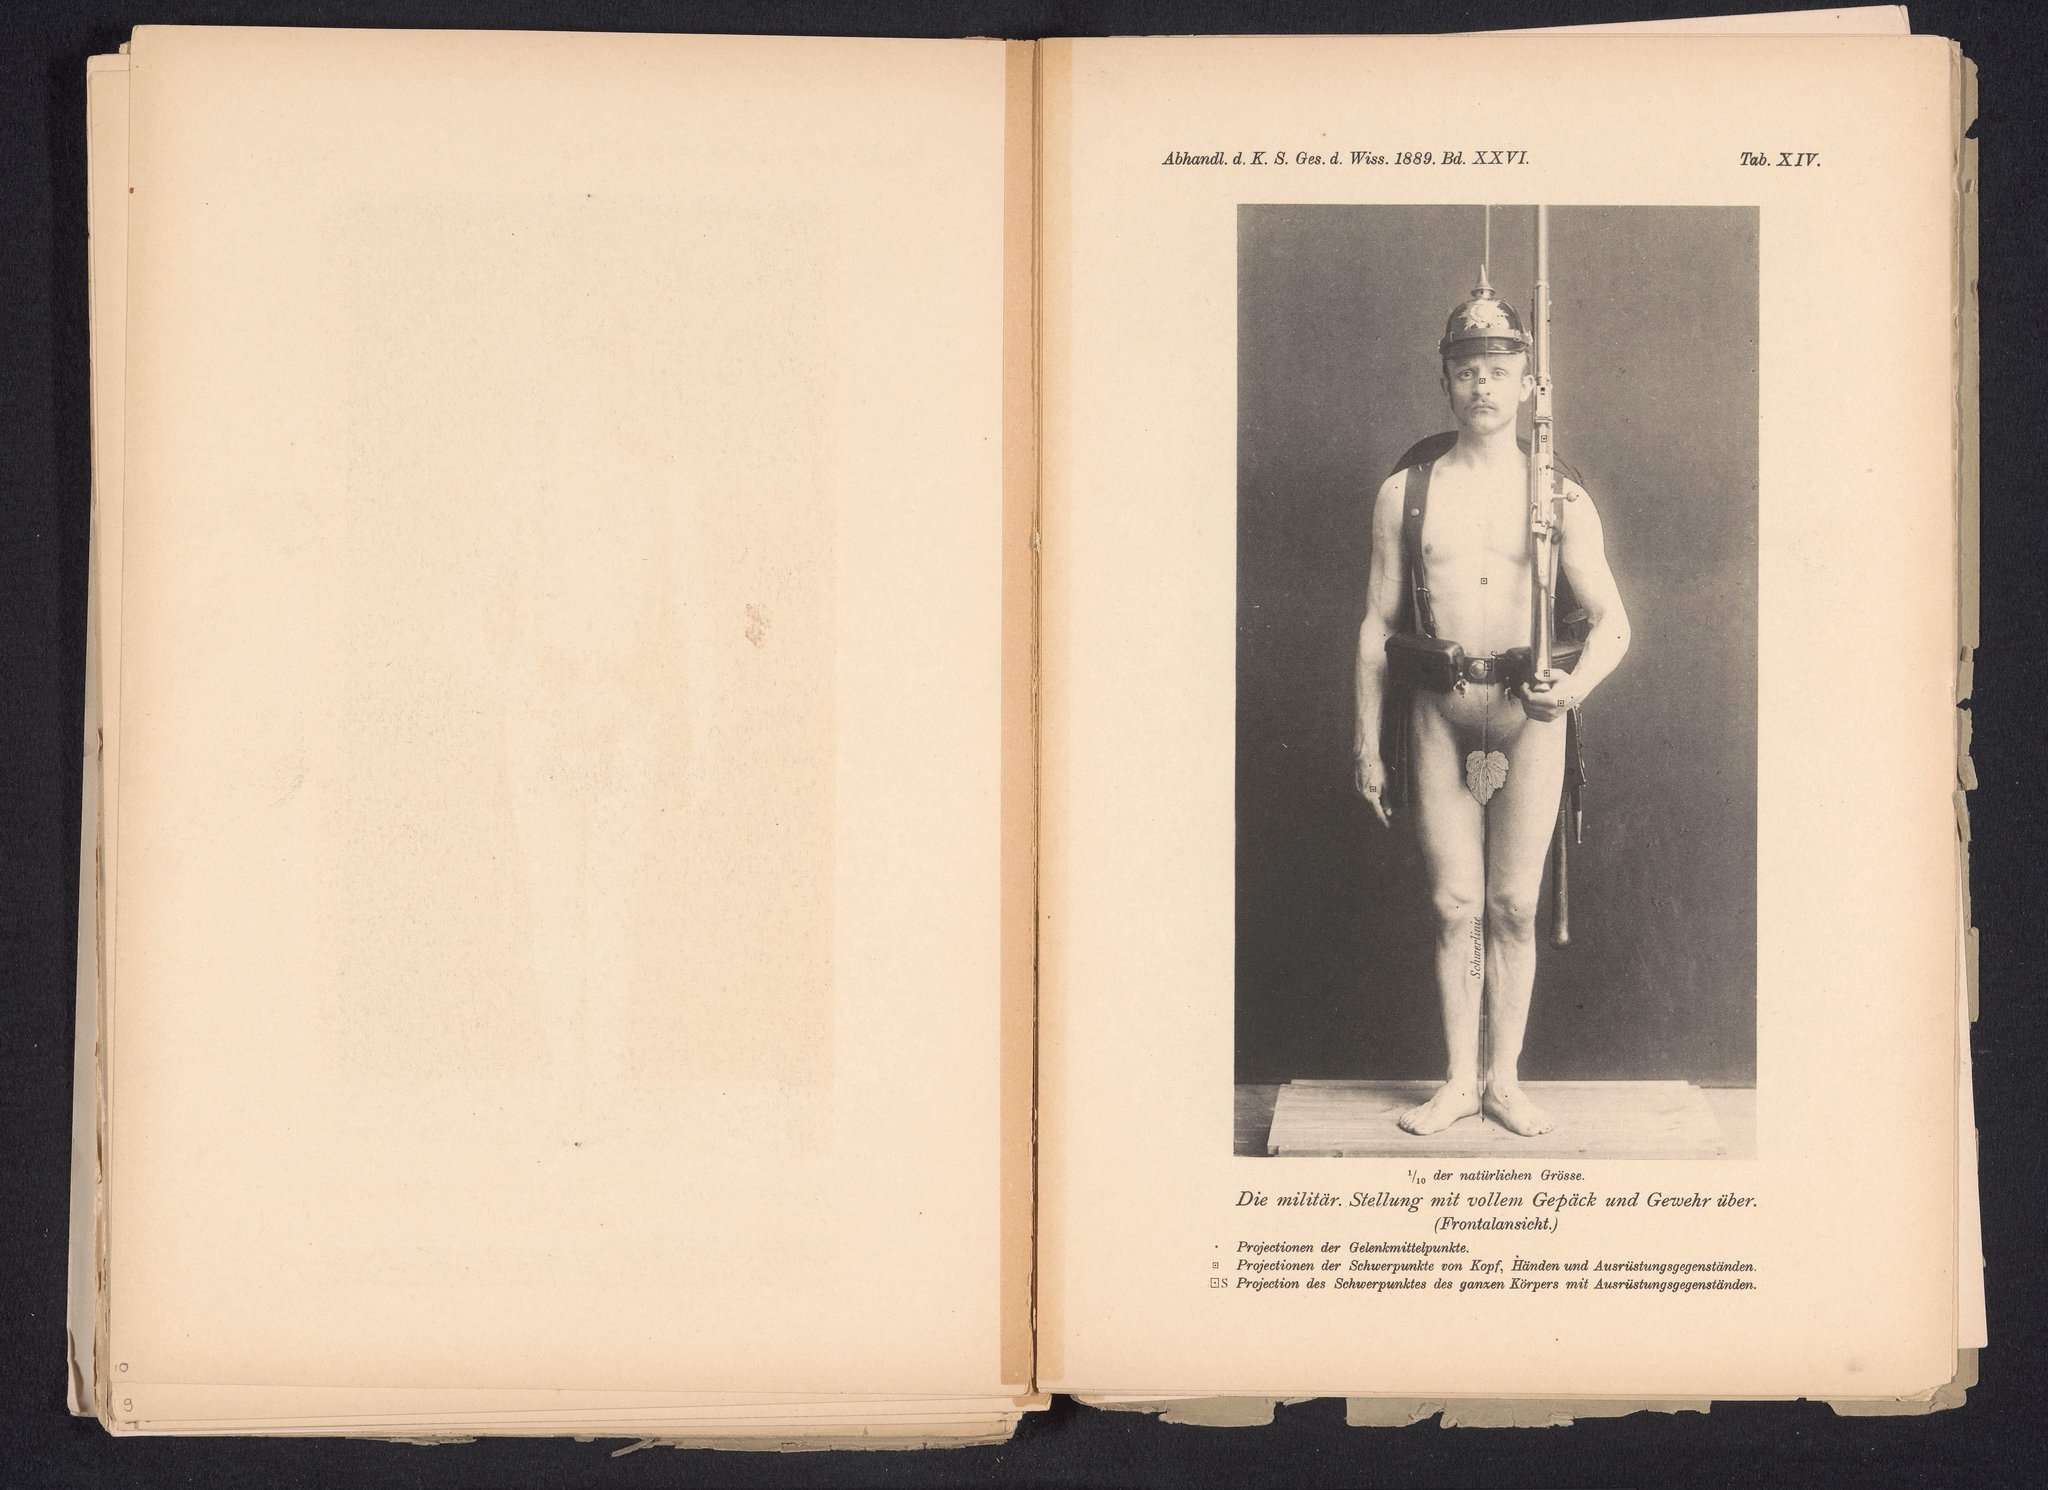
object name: page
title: Die militär. Stellung mit vollem Gepäck und Gewehr über. (Frontalansicht)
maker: Anonymous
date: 1880-1890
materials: paper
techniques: photograph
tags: anatomy (non-medical), firearms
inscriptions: inscription: ‘Schwerlinie. 1/10 der natürlichen Grösse. Projectionen der Gelenkmittelpunkte. Projectionen der Schwerpunkte von Kopf, Händen und Ausrüstungsgegenständen. Projection des Schwerpunkte des ganzen Körpers mit Ausrüstungsgegenständen.’, number: ‘Tab. XIV.’